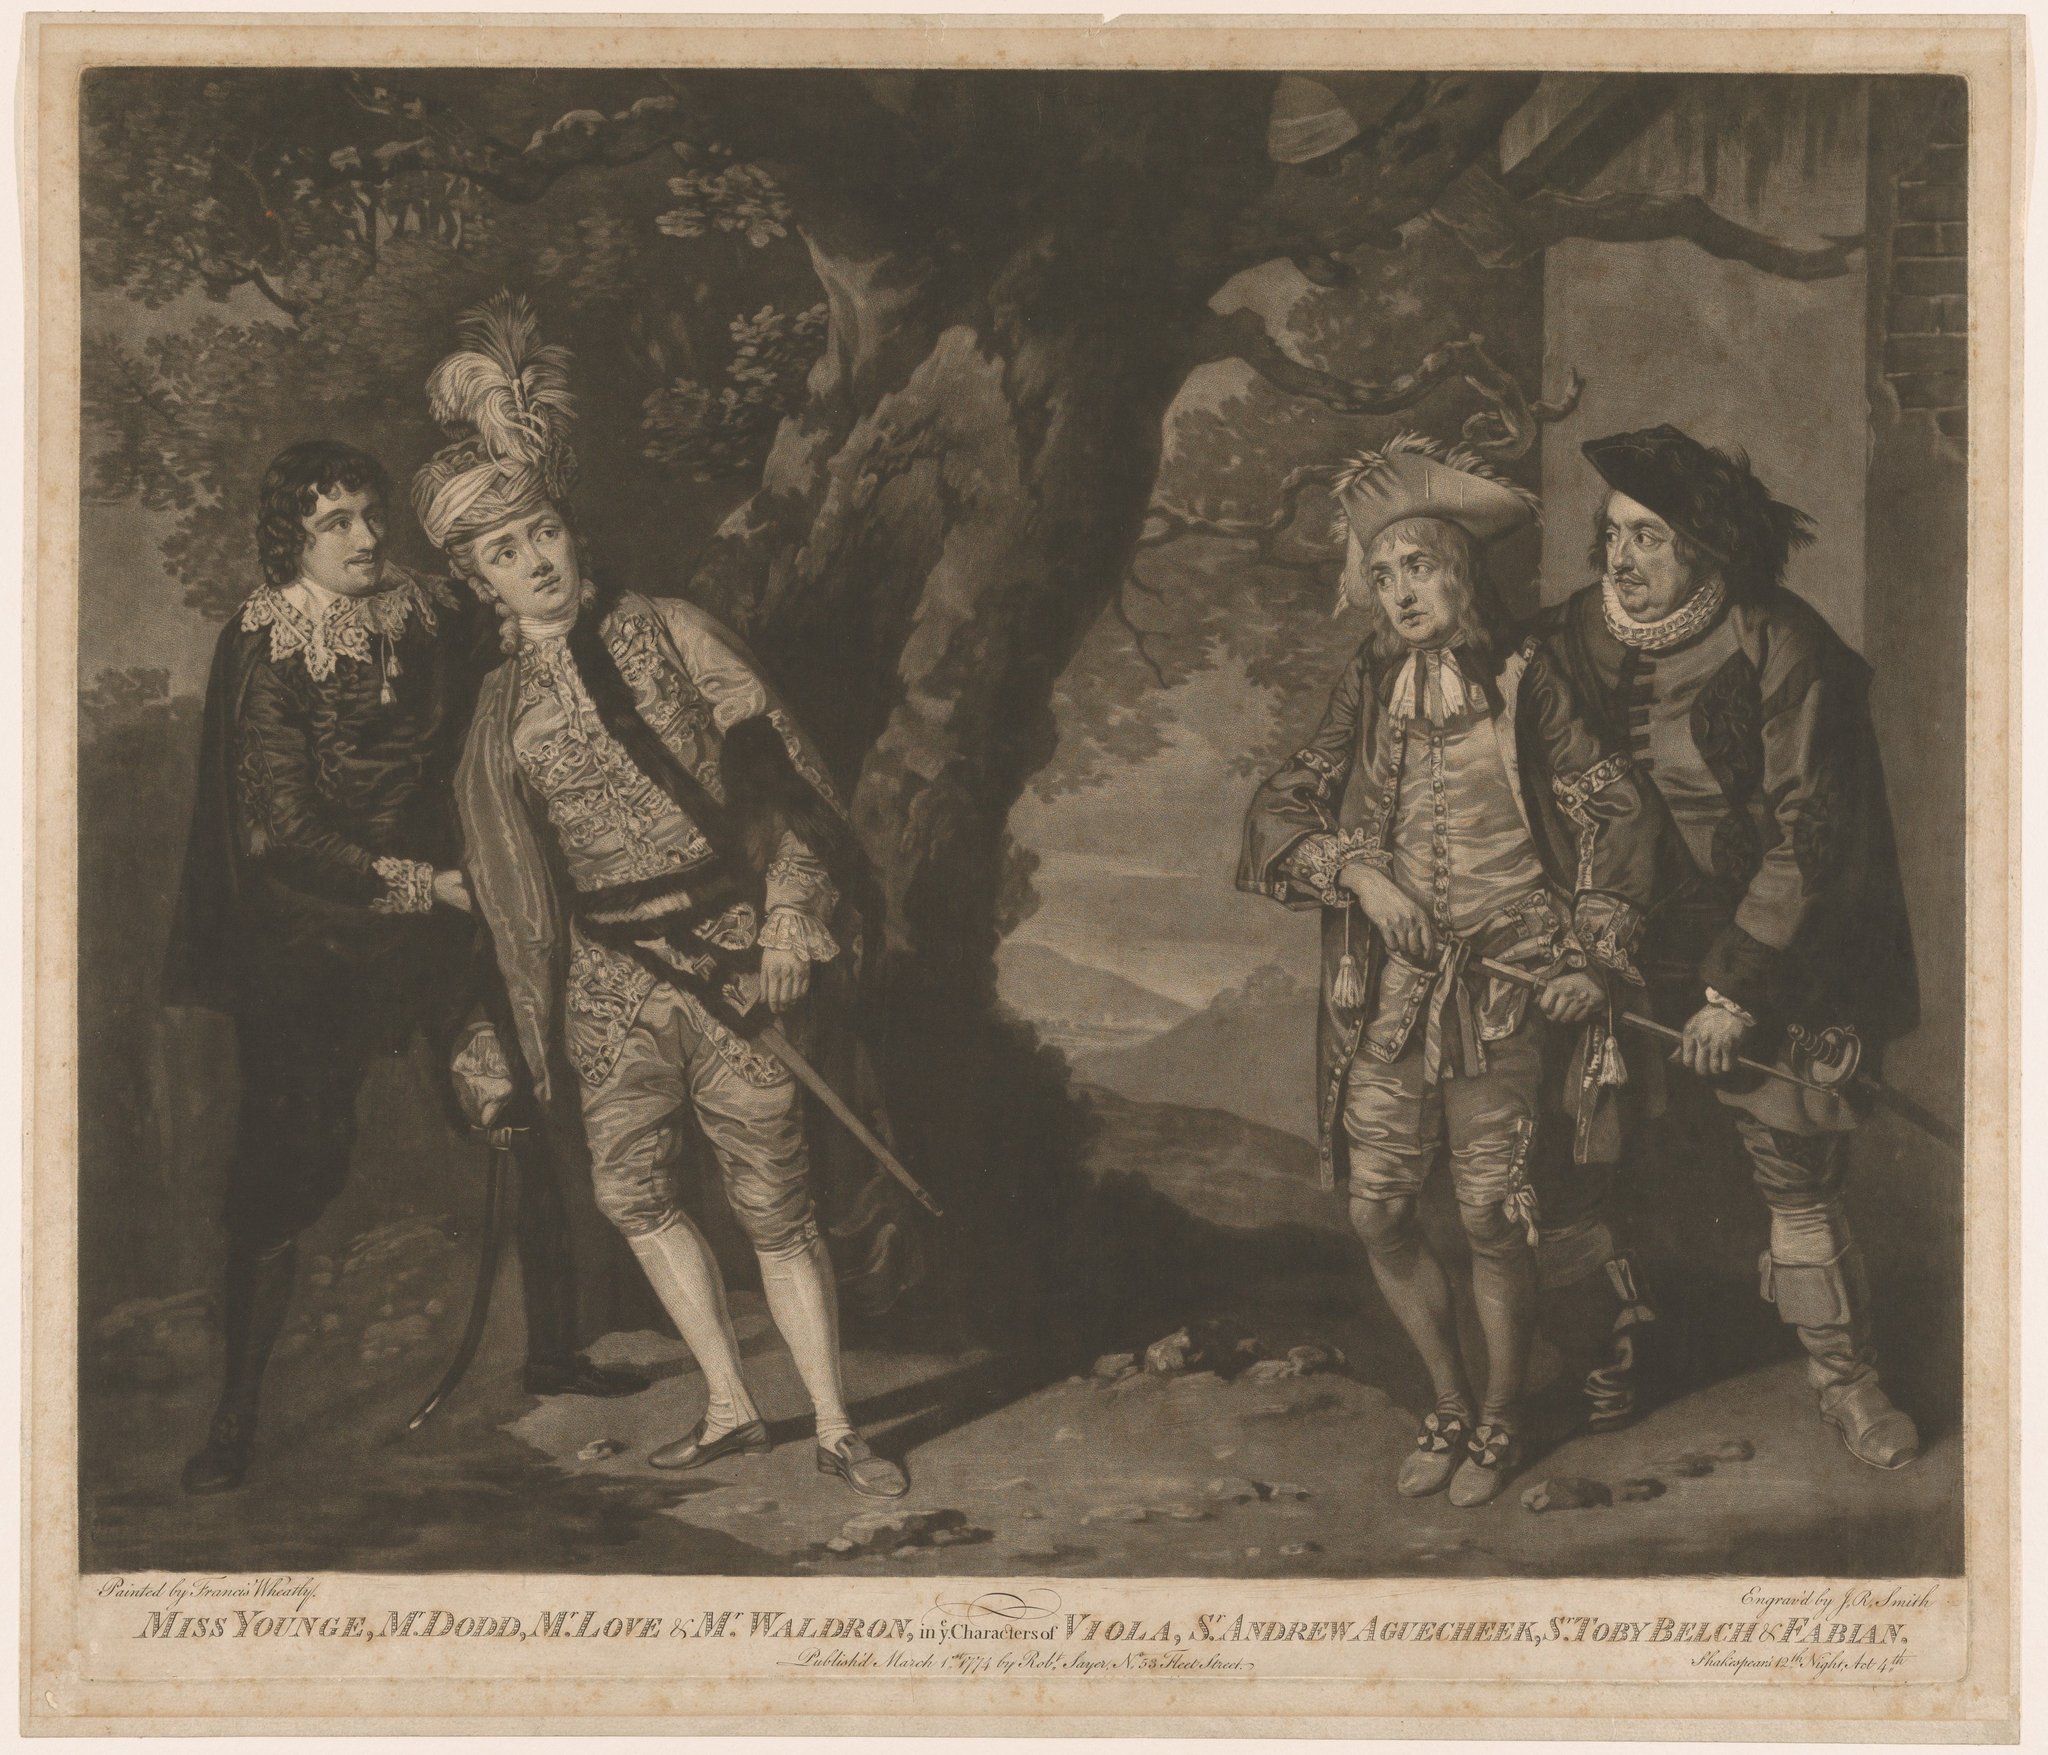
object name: print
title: Miss Younge, Mr. Dodd, Mr. Love, and Mr. Waldron, in th Characters of Viola, Sir Andrew Aguecheek, Sir Toby Belch, and Fabian (Shakespeare, Twelfth Night, Act 3, Scene 4)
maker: john raphael smith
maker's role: engraver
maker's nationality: british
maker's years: 1751-1812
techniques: mezzotint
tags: shakespeare,men,women,actors,actresses